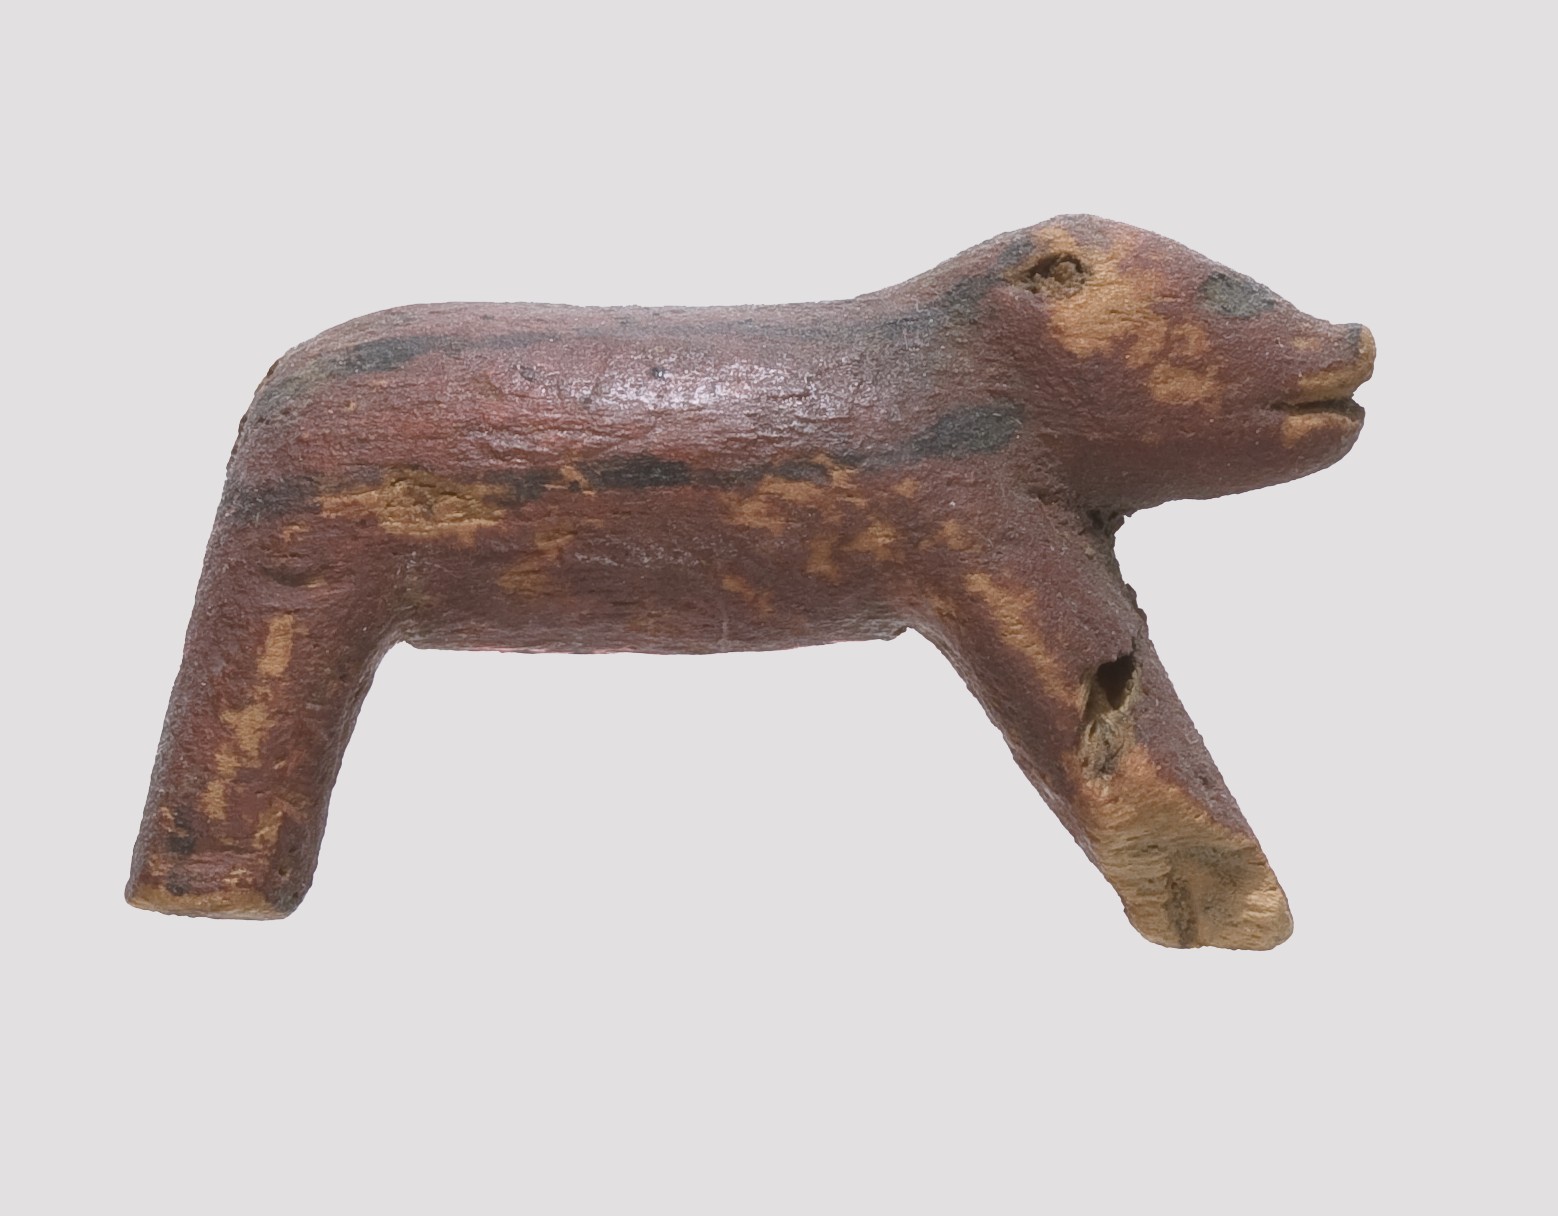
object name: figurine, piglet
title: Piglet figurine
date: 1700 BCE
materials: paint, wood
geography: egypt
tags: pigs